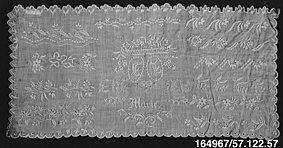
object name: sampler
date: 1848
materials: cotton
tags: flowers,leaves